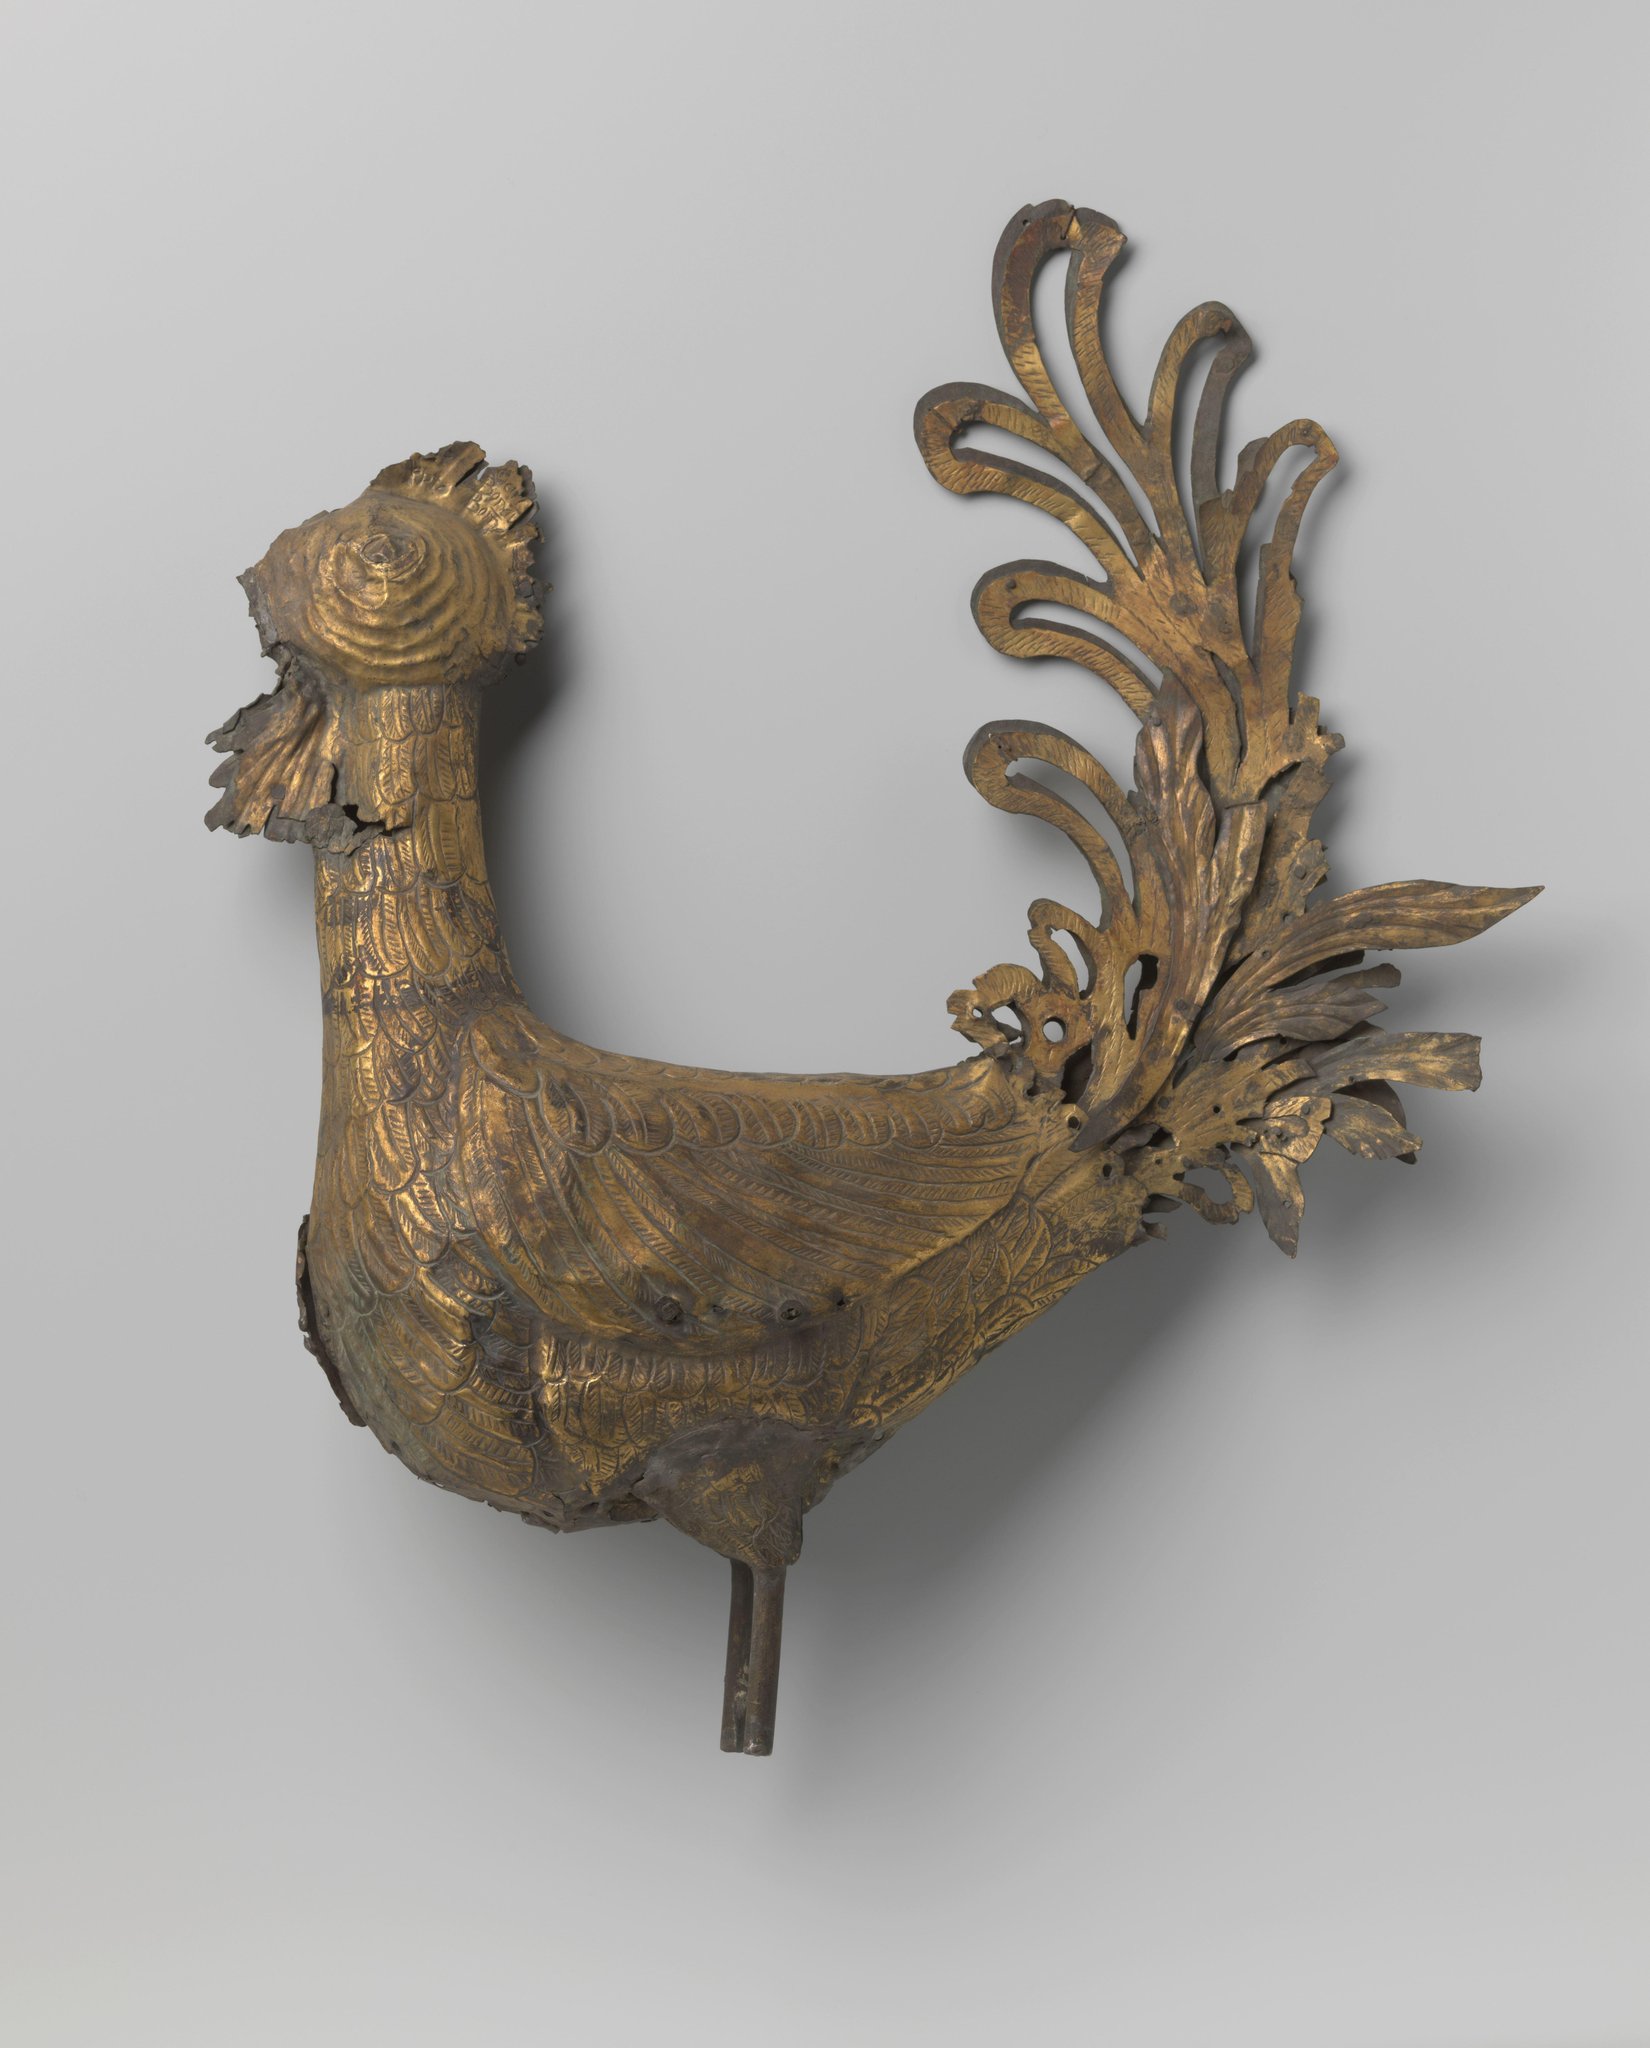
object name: weather vane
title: Windwijzer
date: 1500-1600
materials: copper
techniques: gilding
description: Een verguld koperen windvaan met haan. Kop en staart zijn beschadigd.